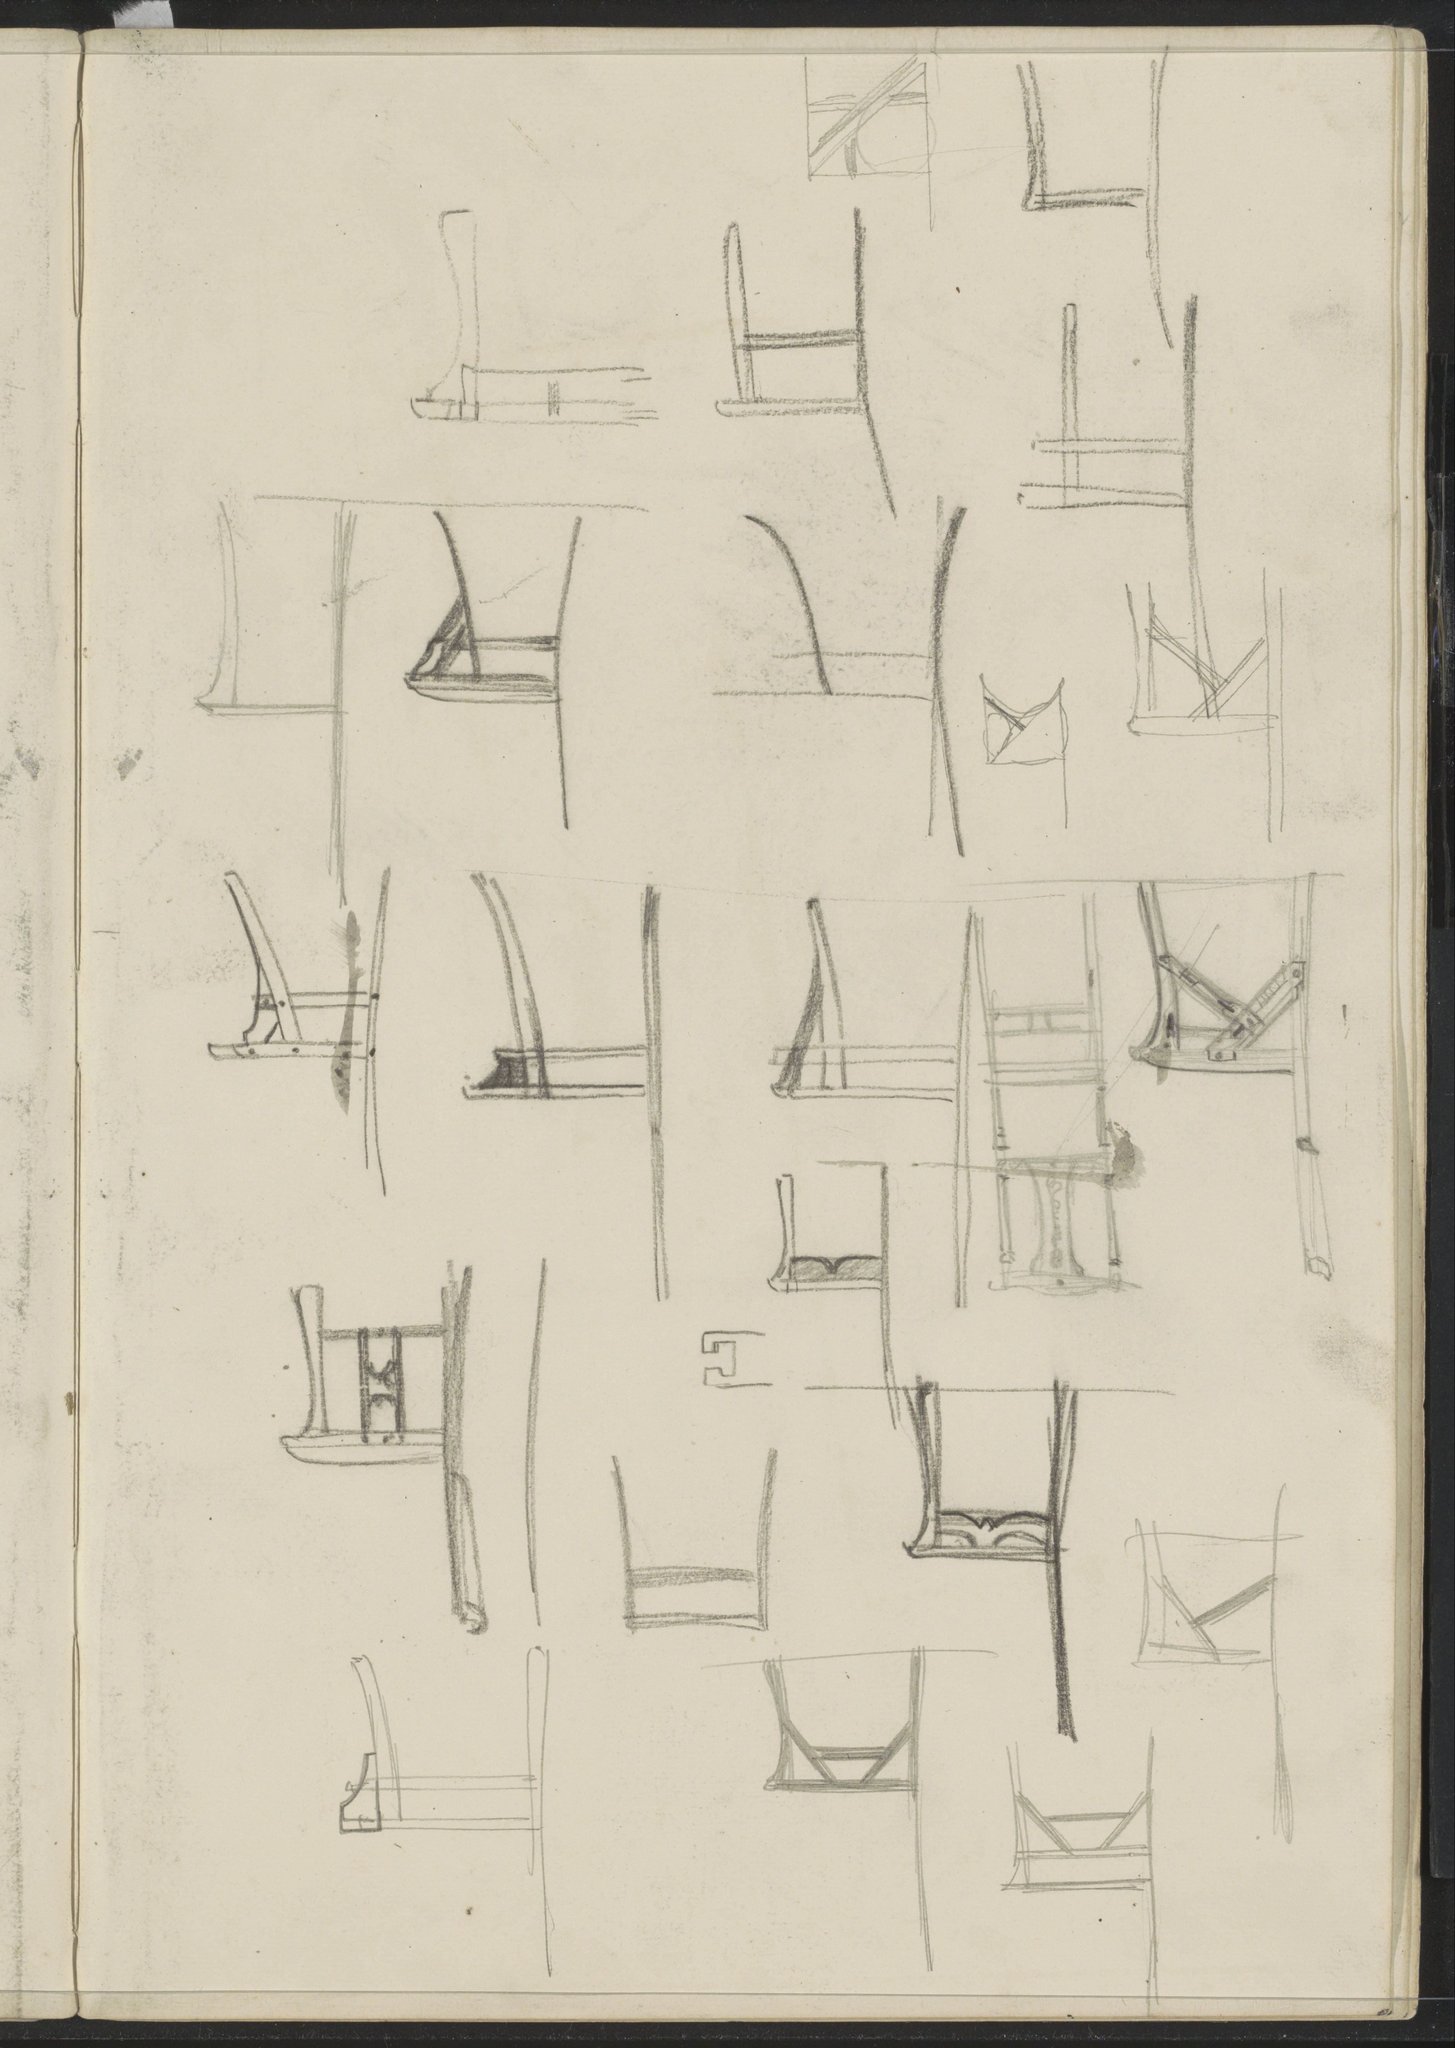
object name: sketchbook leaf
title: Ontwerpen voor stoelen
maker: carel adolph lion cachet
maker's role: draughtsman, print maker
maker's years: 1864-1945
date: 1903-1904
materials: chalk, paper, pencil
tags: chair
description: Blad 10 recto uit een schetsboek met 17 bladen.